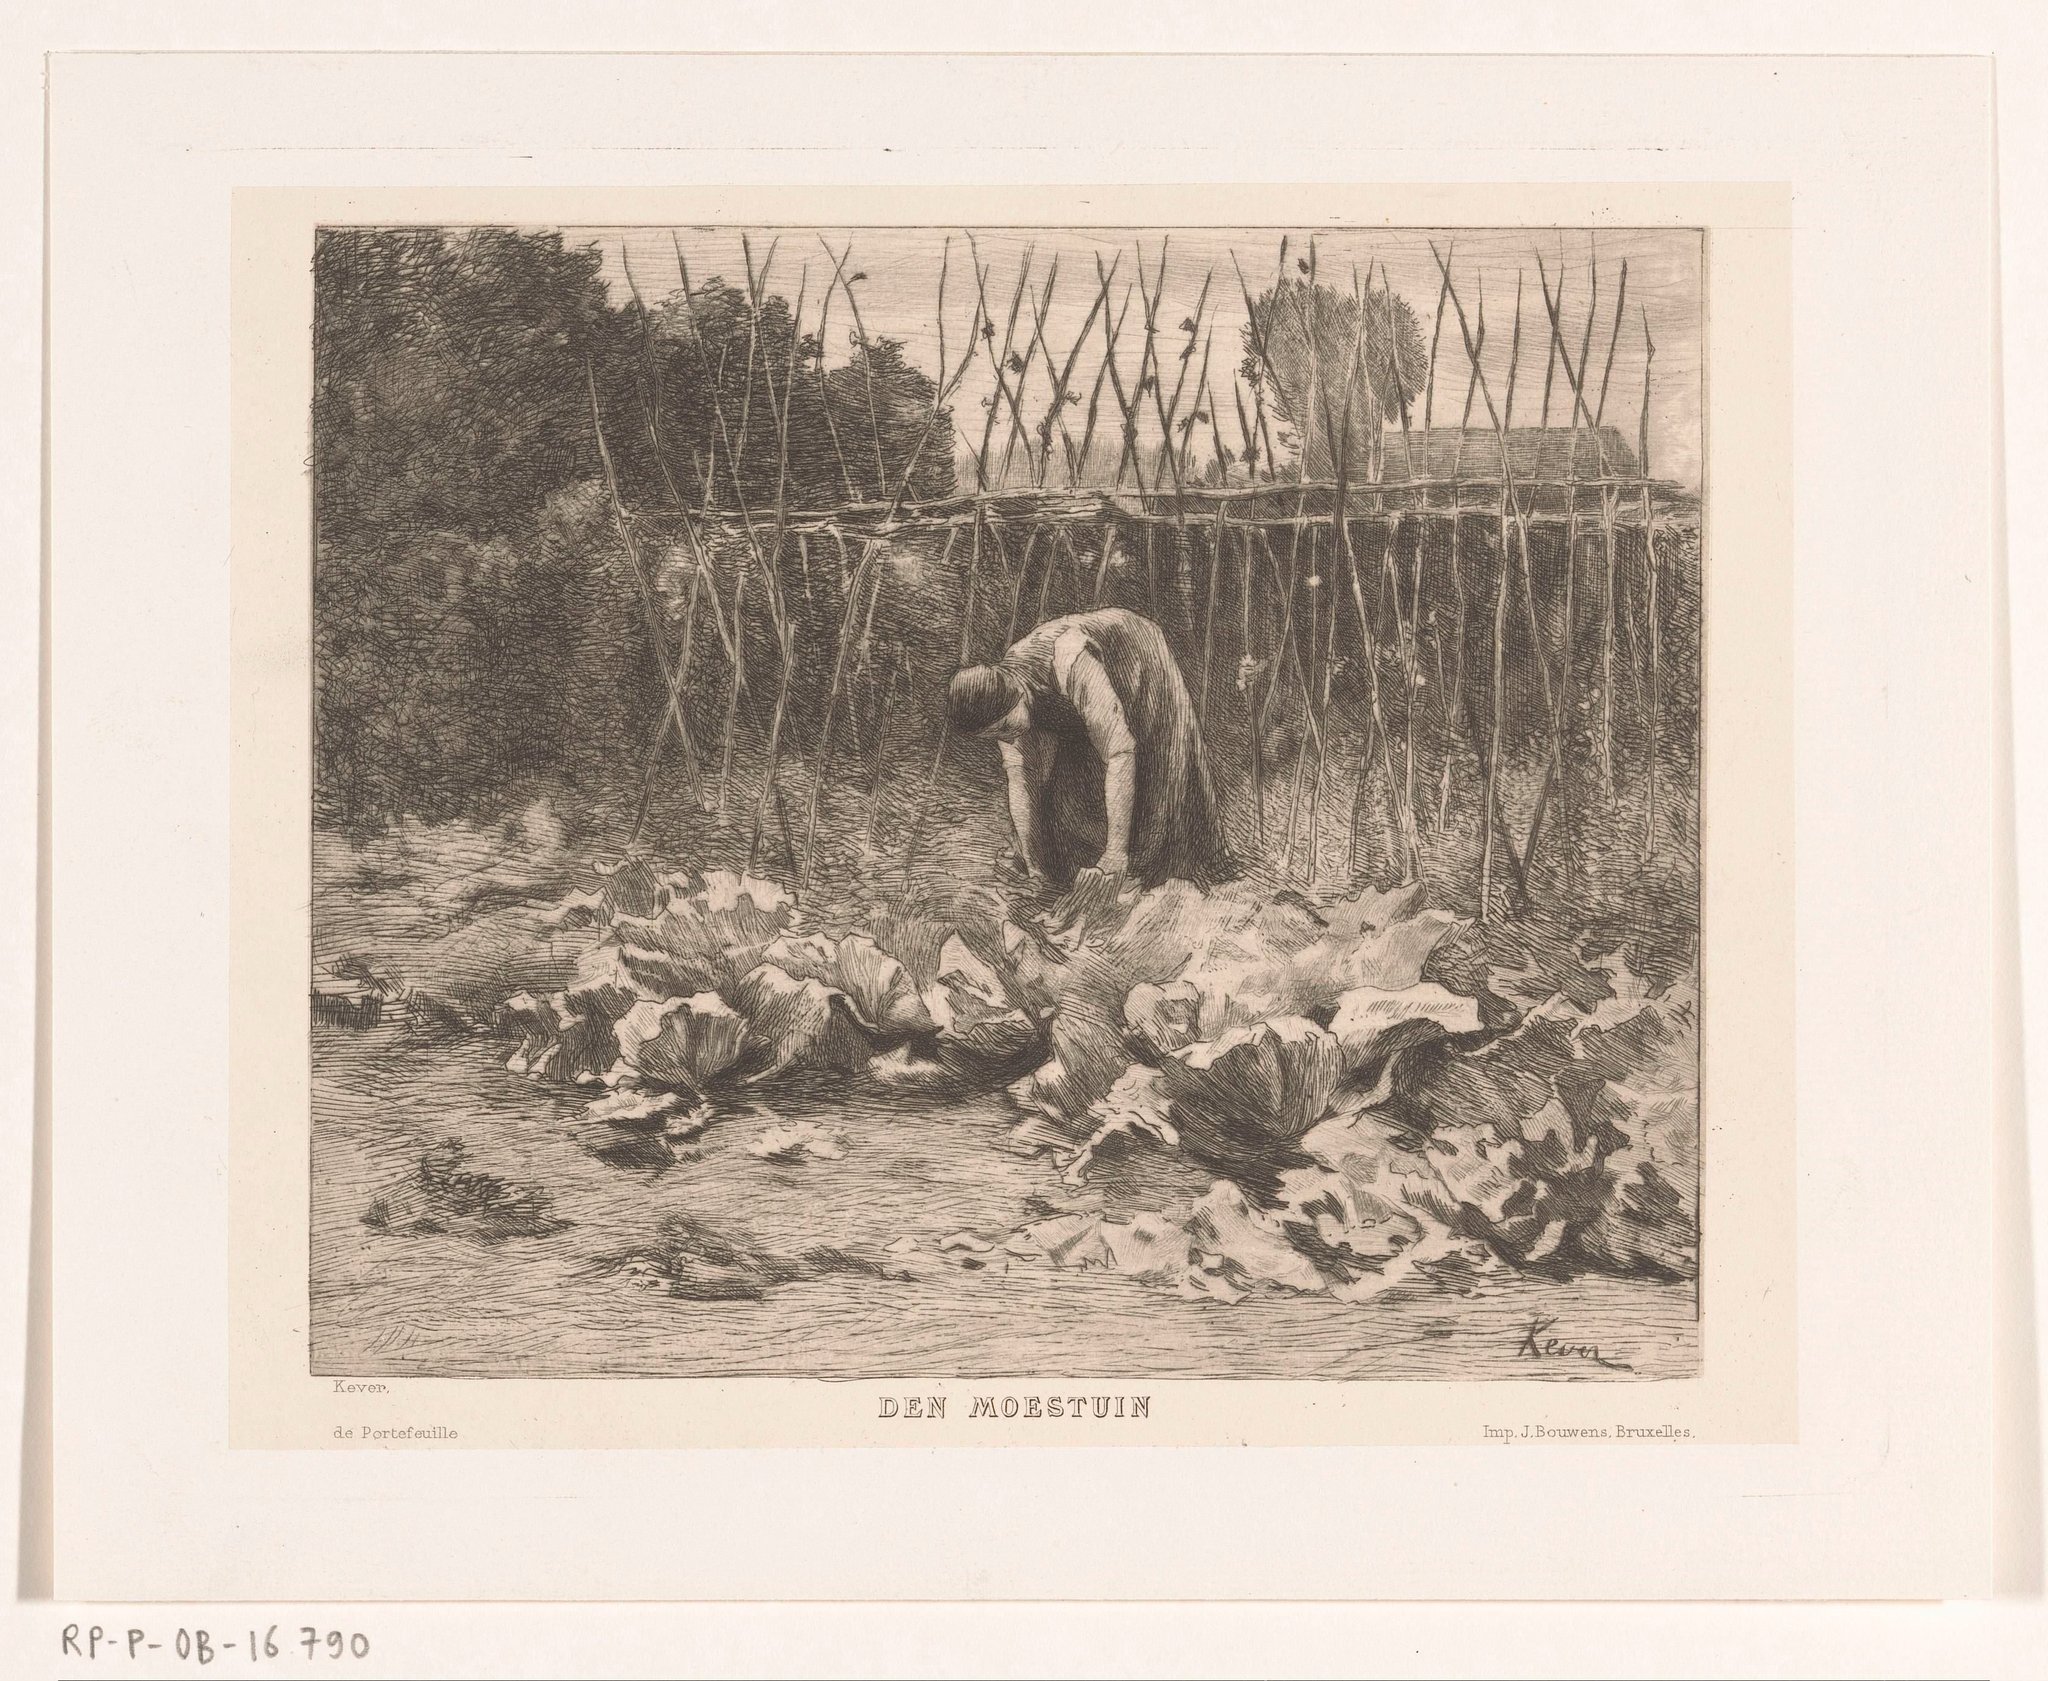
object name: print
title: Den moestuin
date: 1864-1922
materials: paper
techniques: etching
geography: brussels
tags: nursery, market garden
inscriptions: collector's mark: Lugt 2228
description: Een vrouw aan het werk in een moestuin met bonenranken.